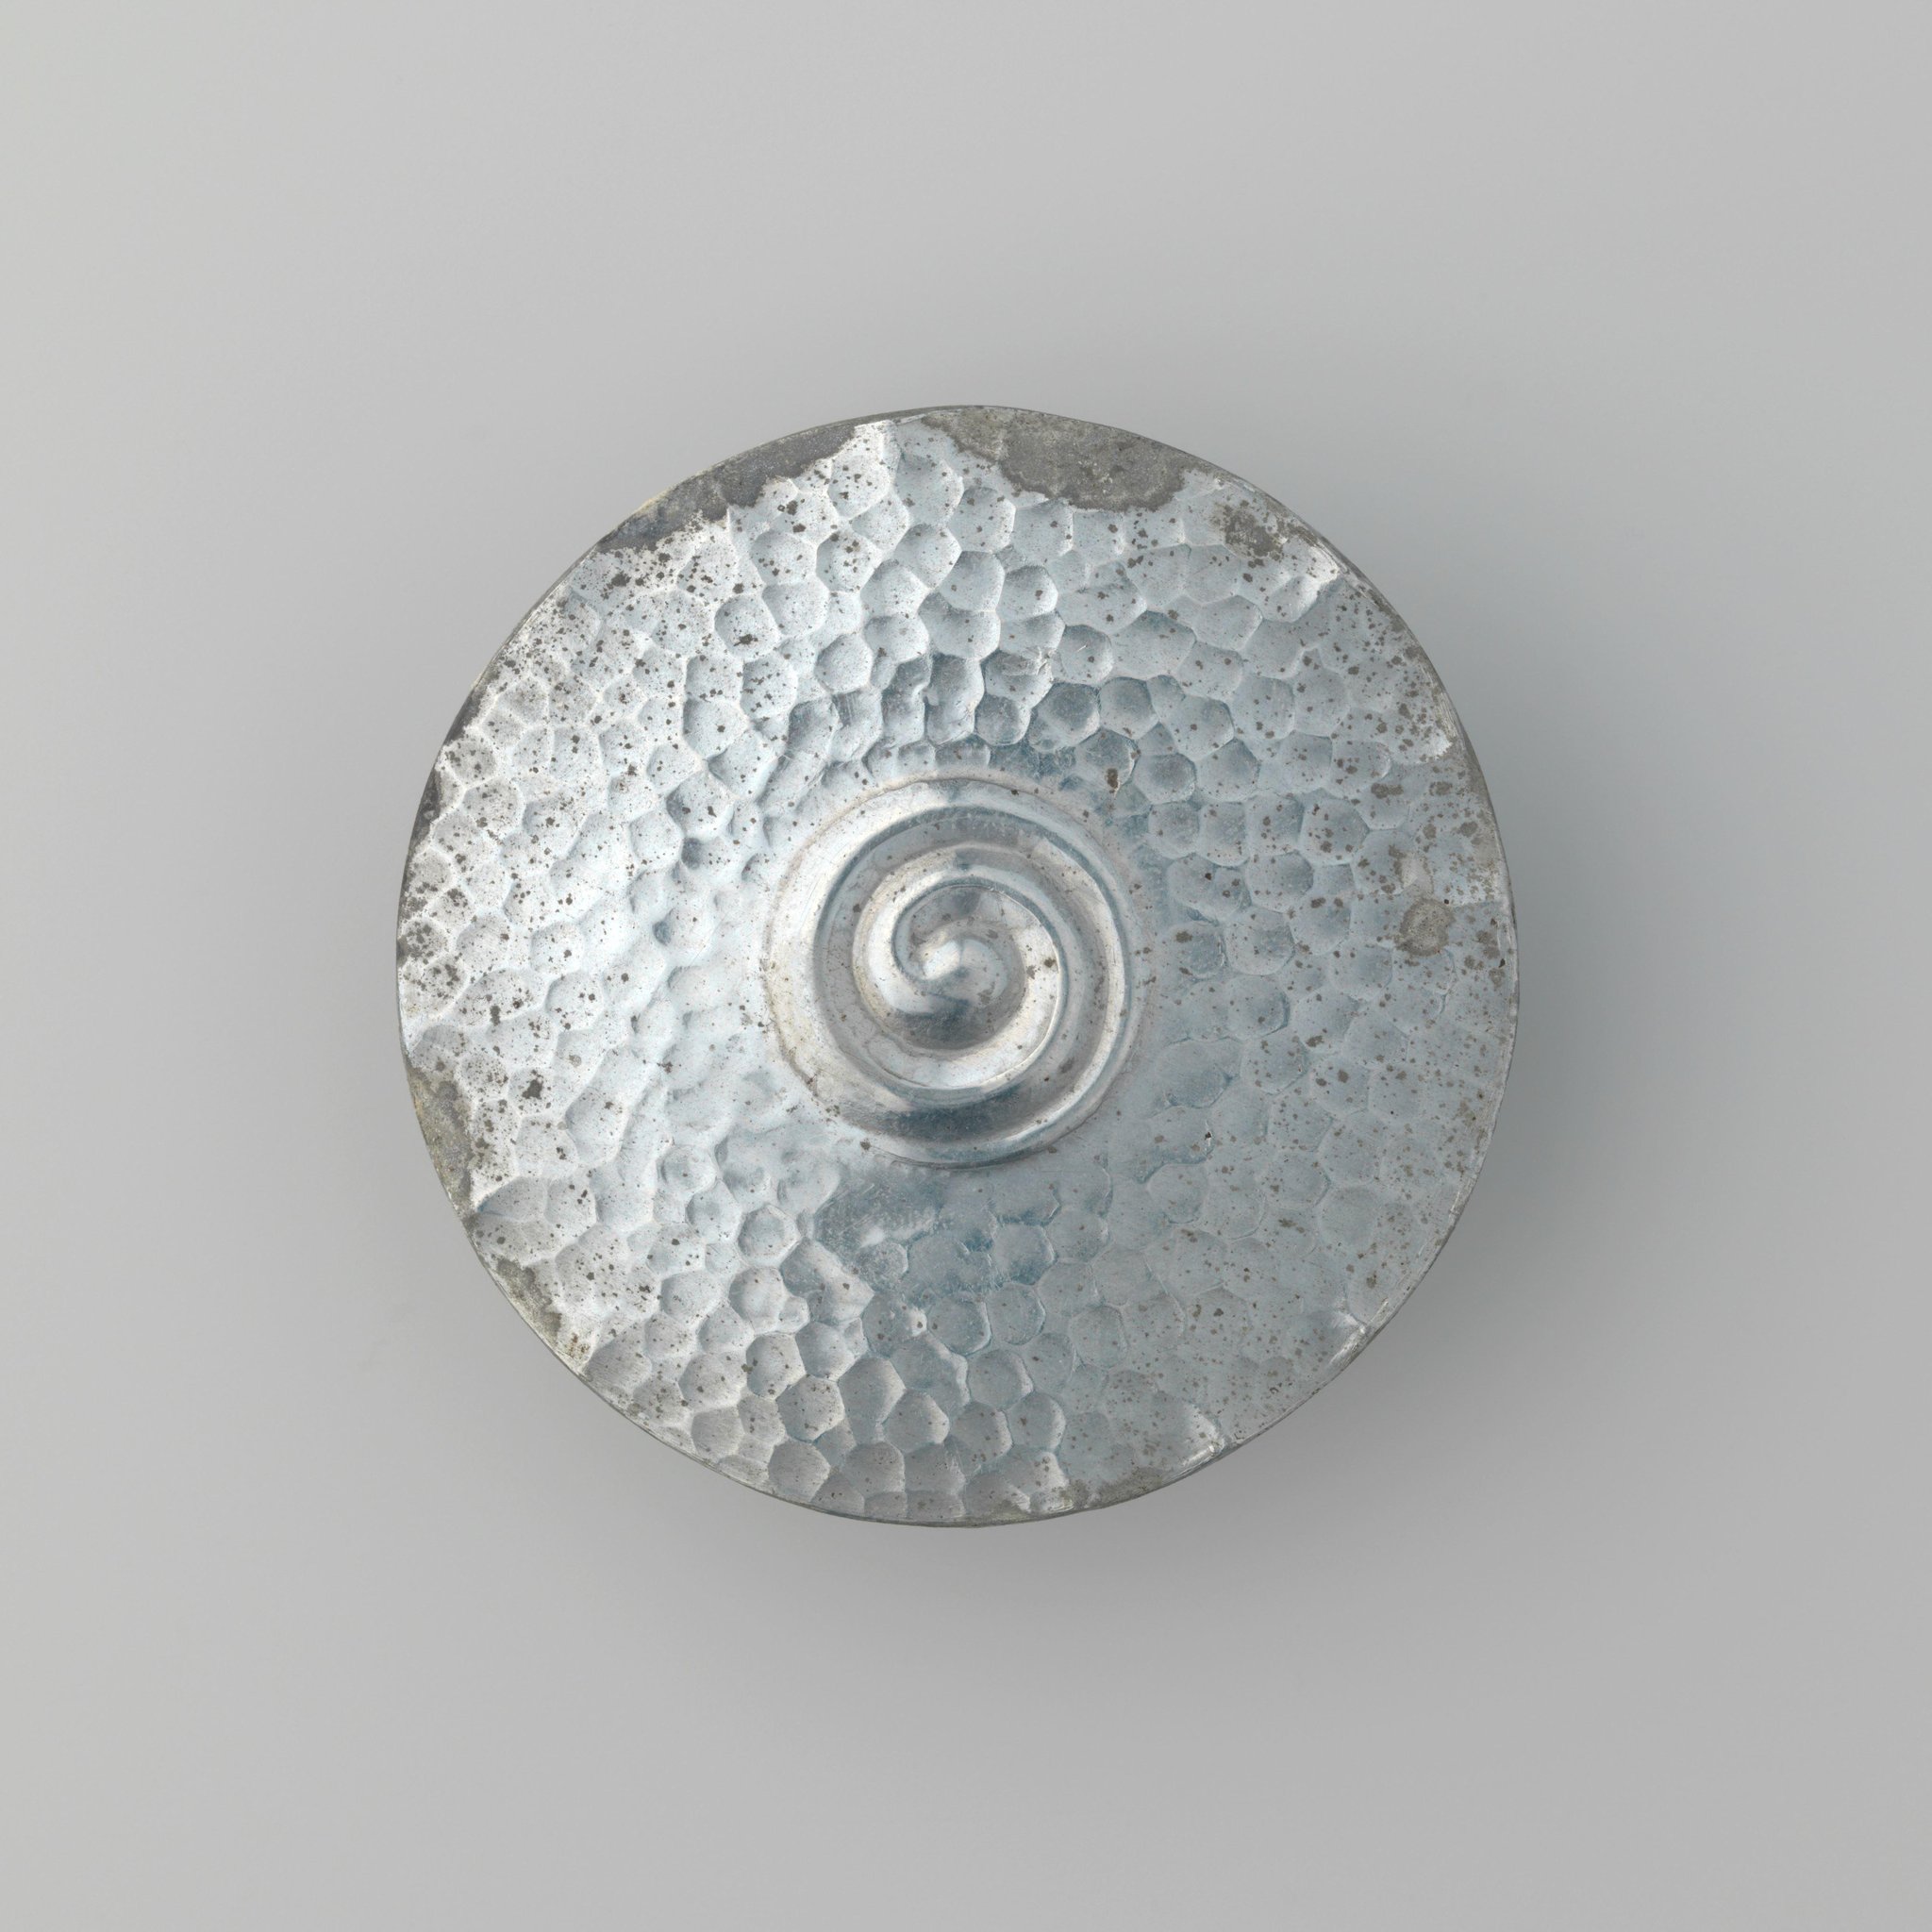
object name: plate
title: Rond plaatje van zilverkleurig onedel metaal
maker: Anonymous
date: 1940-1945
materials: metal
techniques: hammering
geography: netherlands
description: Rond plaatje van zilverkleurig onedel metaal. In een gehamerde rand zit centraal in reliëf een cirkelvorm met daarin een spiraal. Het plaatje was bedoeld om nog een brochering achter te zetten.